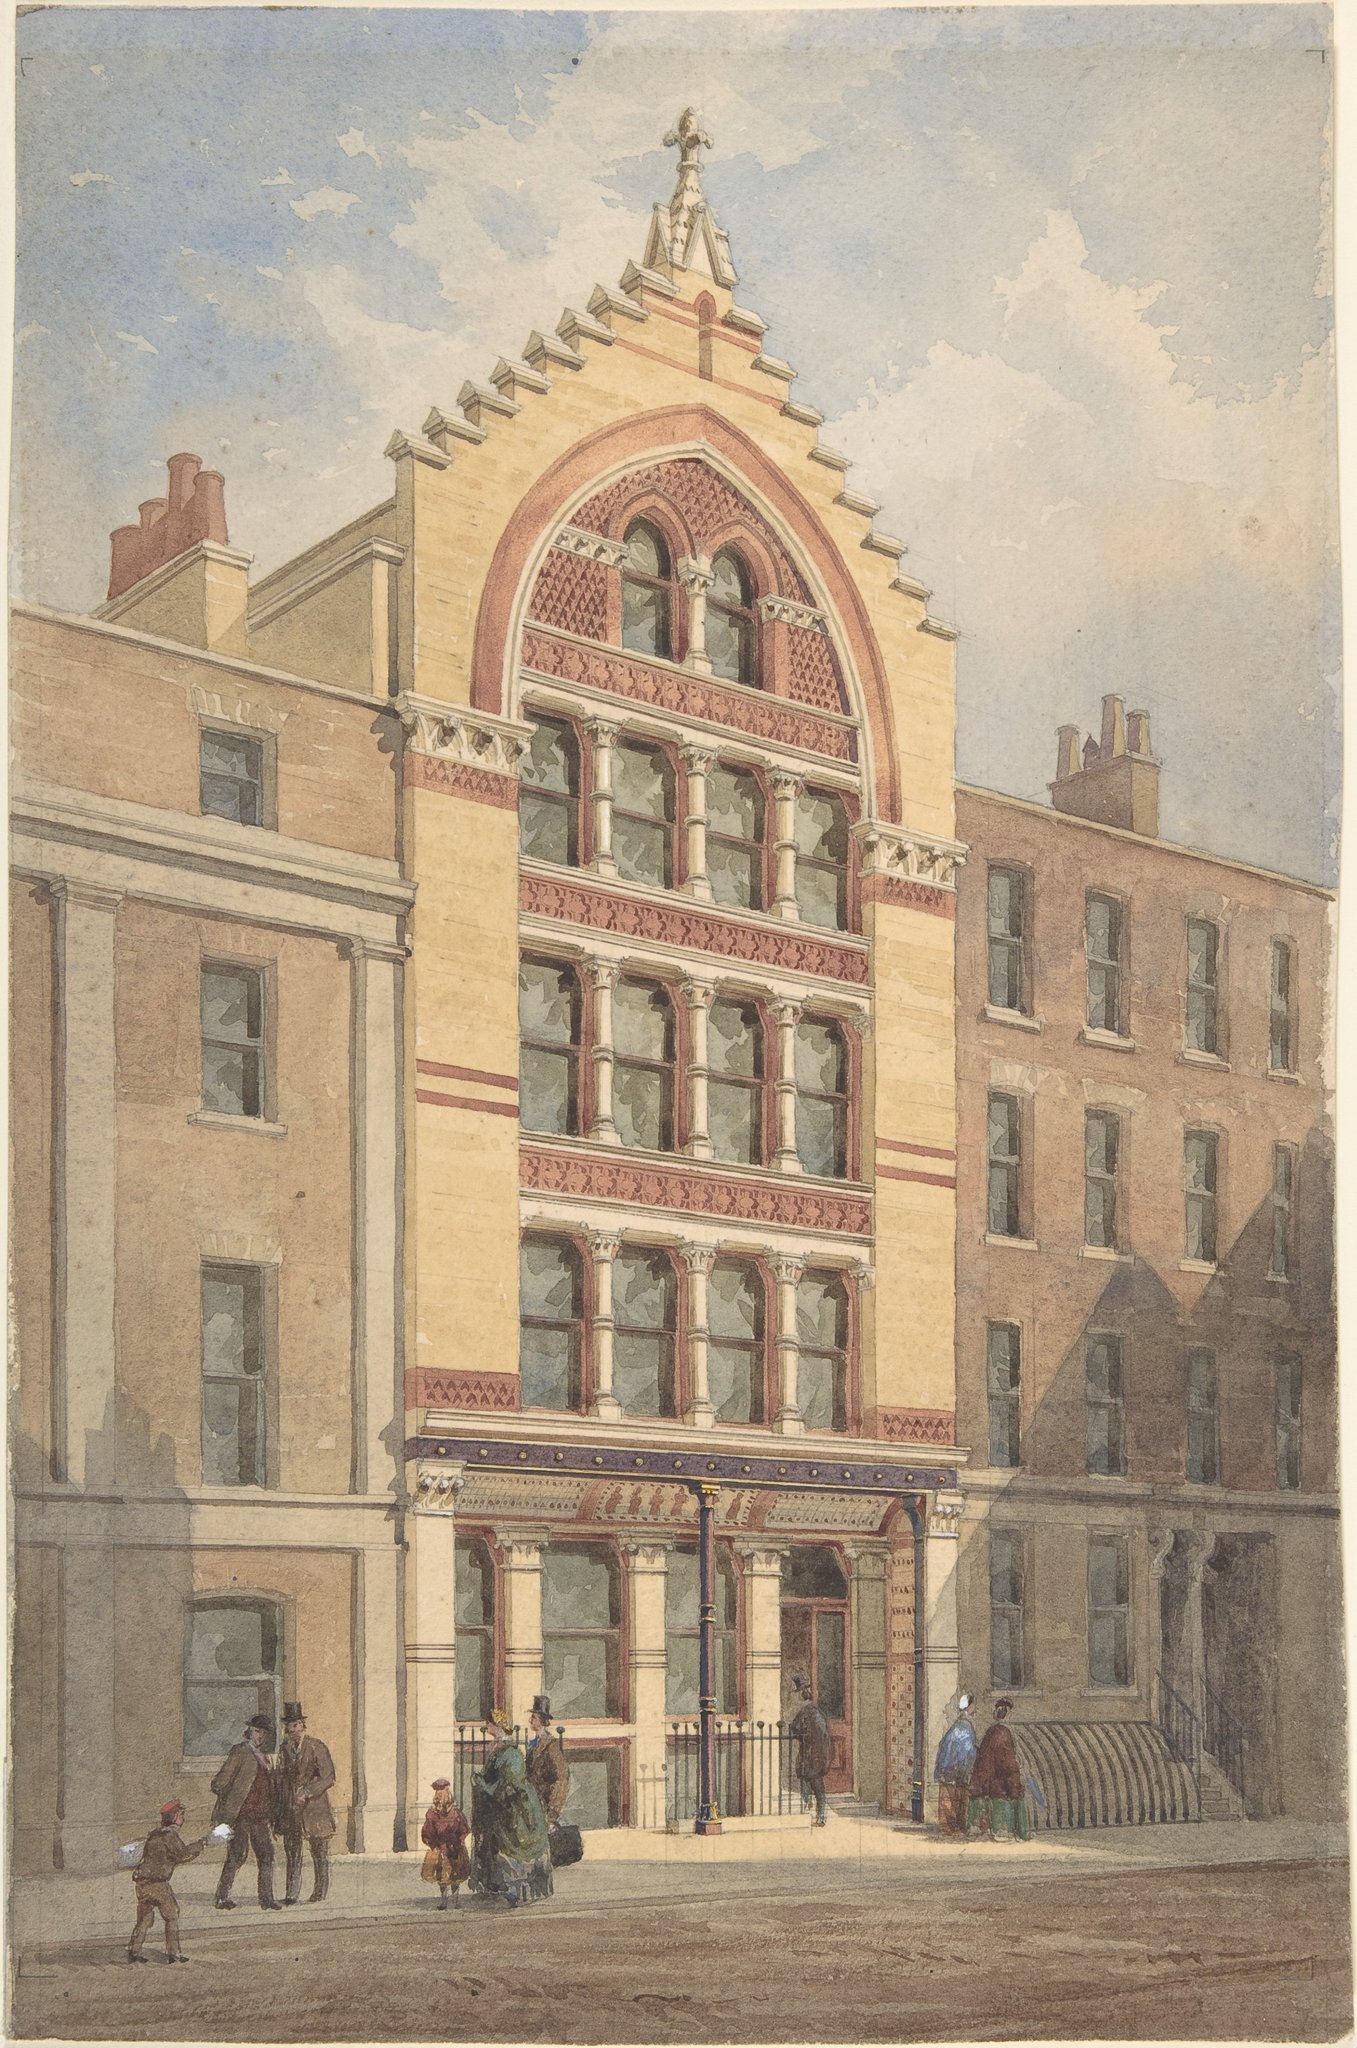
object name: drawing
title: Façade of a Commercial Building, Venetian Gothic Style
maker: anonymous, british, 19th century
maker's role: artist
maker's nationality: british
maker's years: 1800-1900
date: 1870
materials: watercolor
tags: architecture,buildings